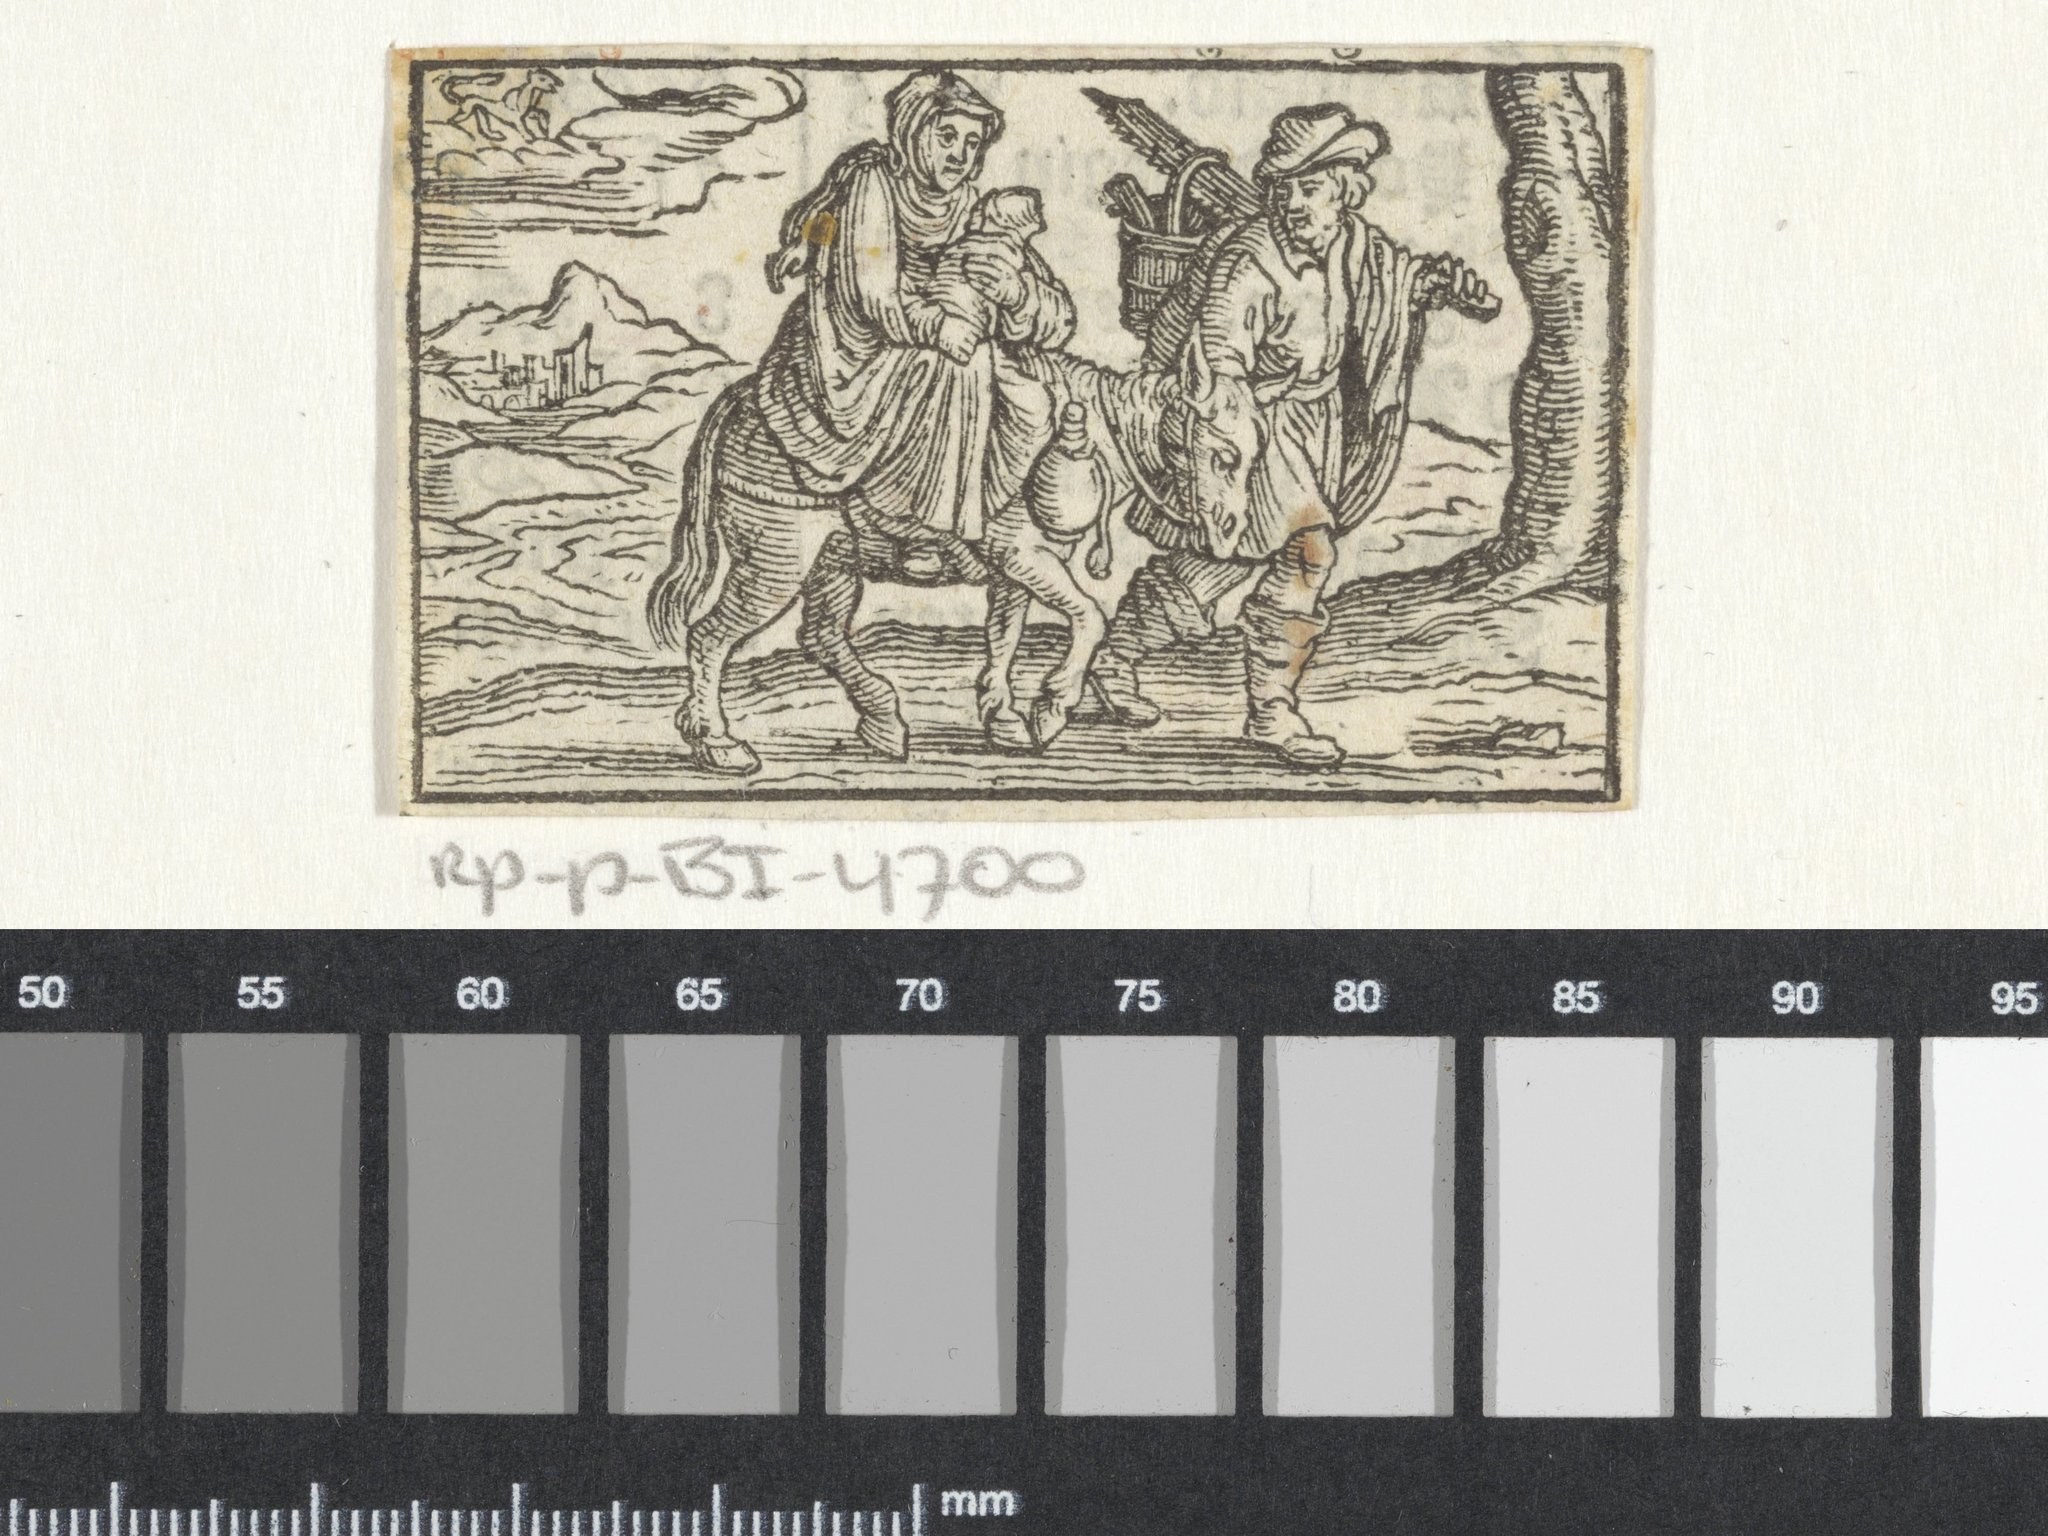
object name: print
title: Juli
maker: Anonymous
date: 1600-1699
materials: paper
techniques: letterpress printing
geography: netherlands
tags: the flight into egypt: mary, joseph, the child (and sometimes others) on their way; mary usually riding on an ass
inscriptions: collector's mark: Lugt 240